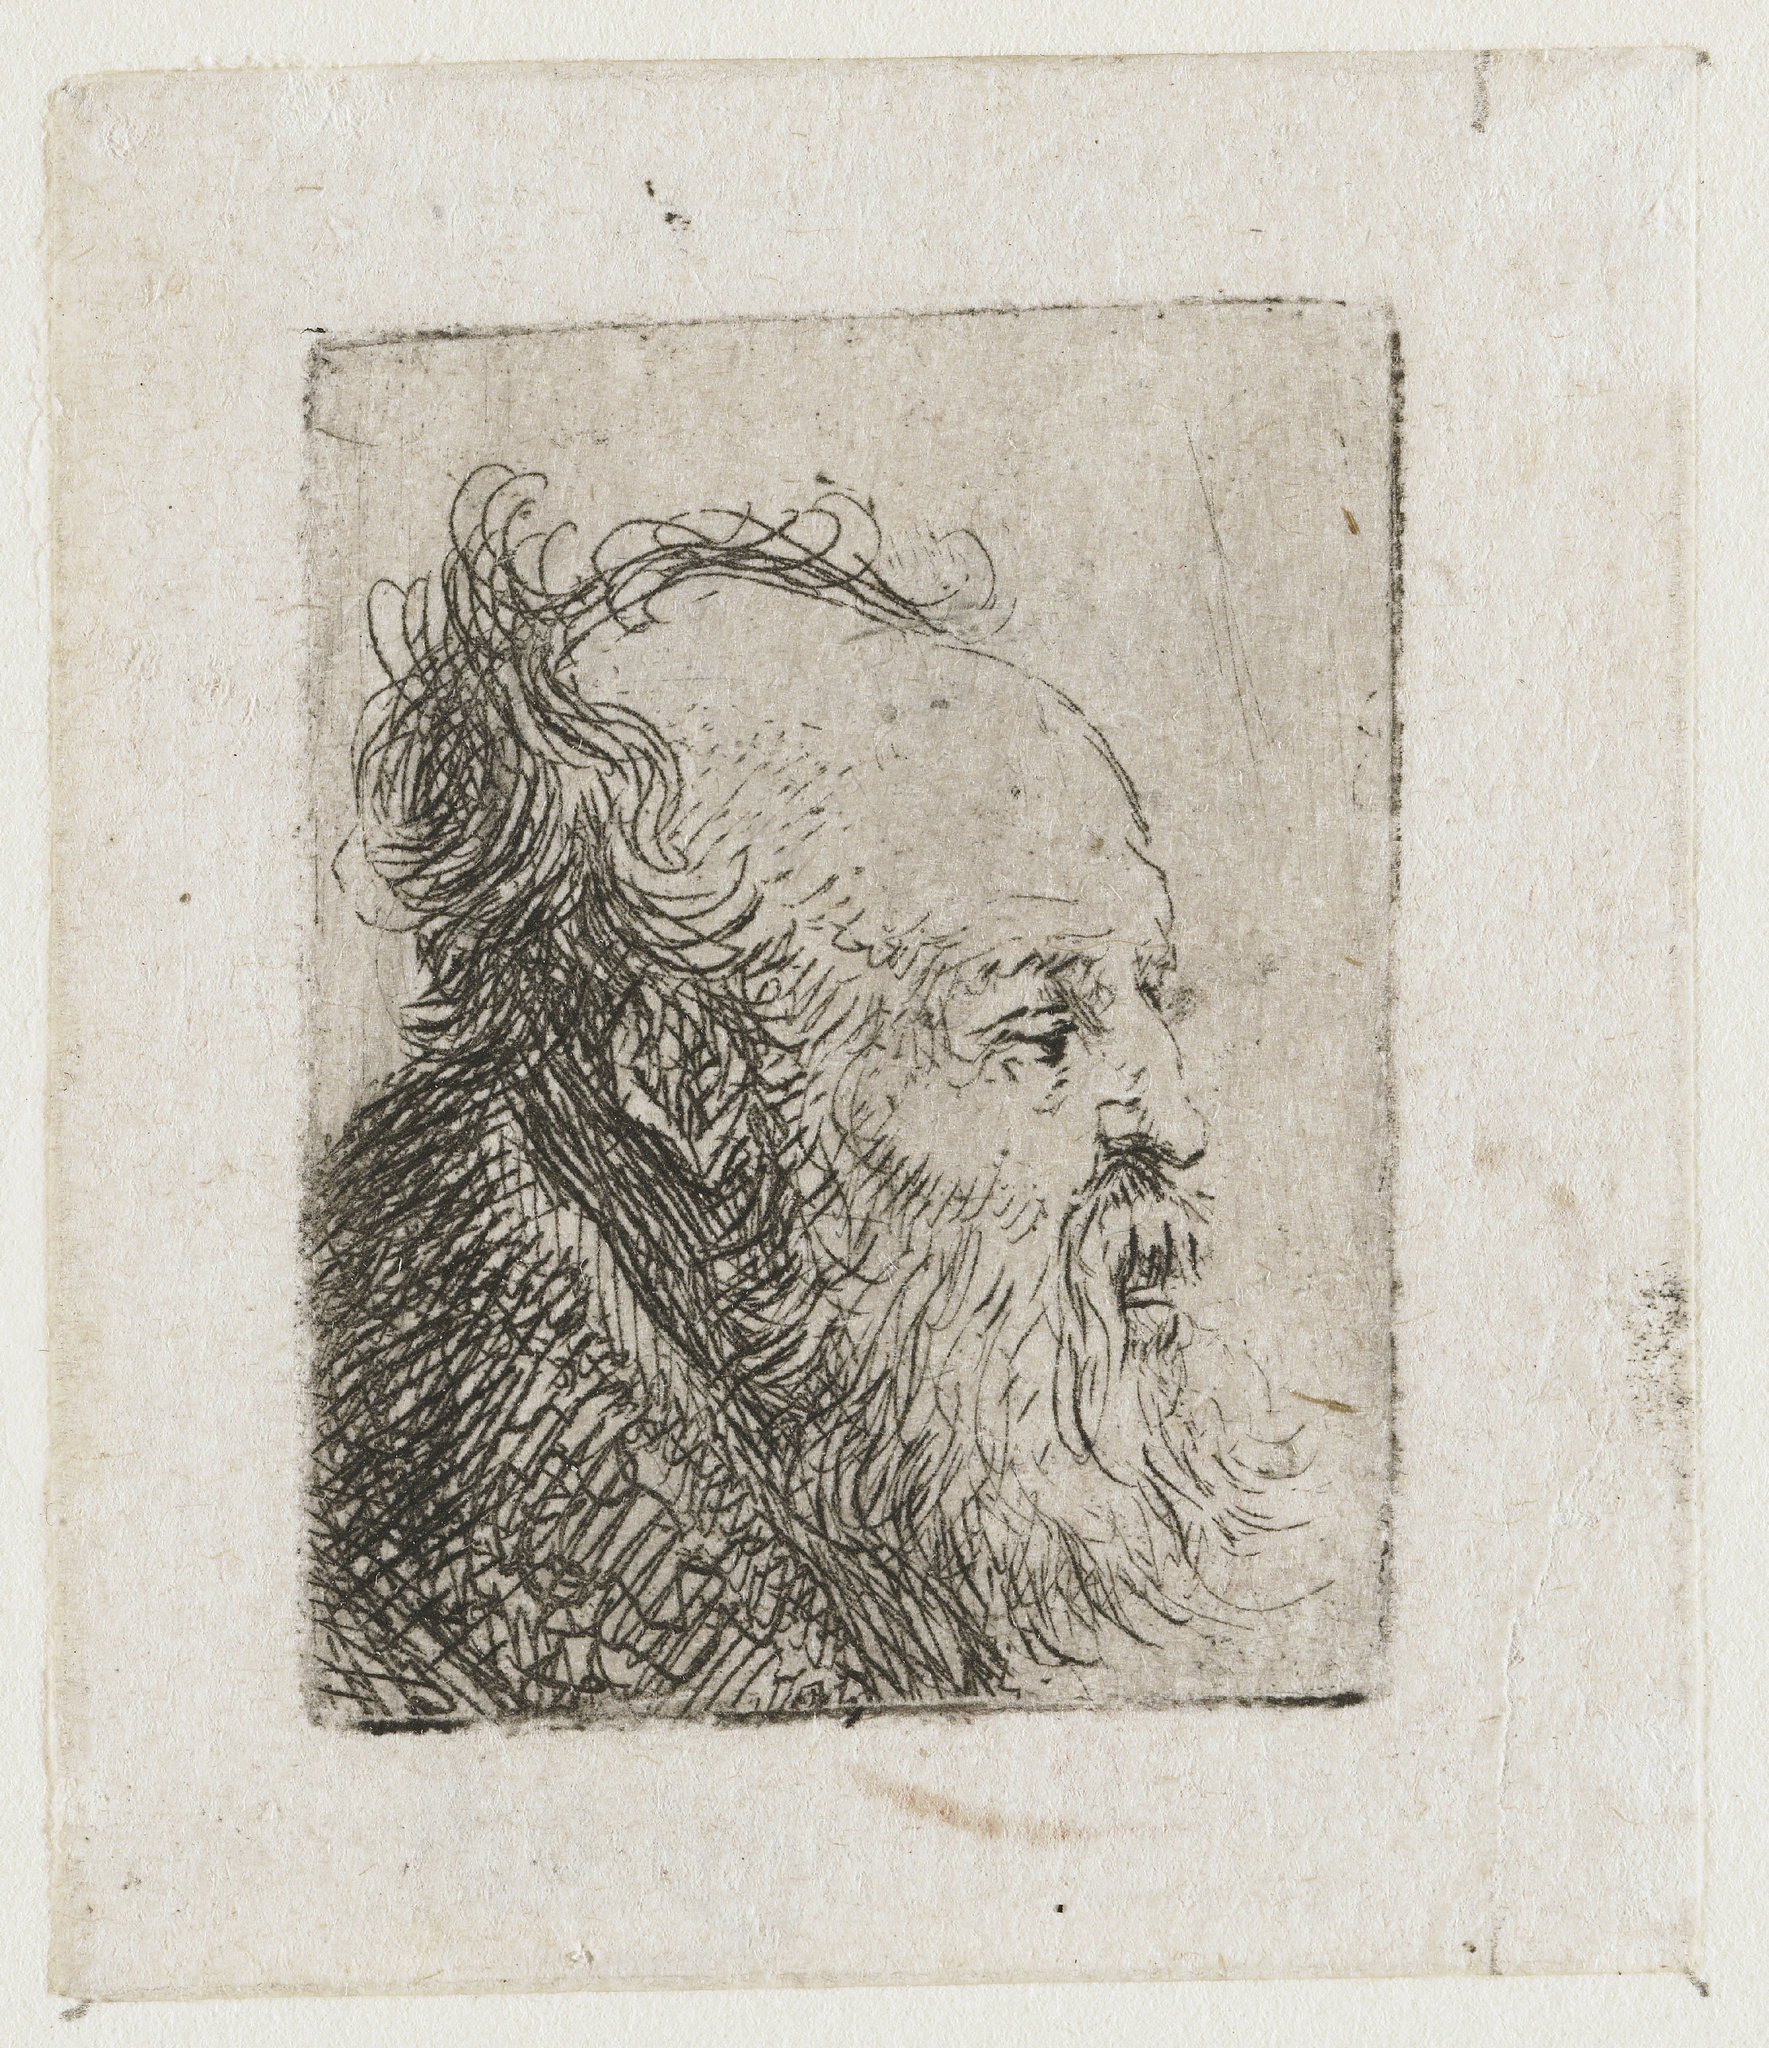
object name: print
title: Sheet of studies of men's heads: old bearded man nearly in profile to right: mouth half open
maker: rembrandt van rijn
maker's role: draughtsman, painter, print maker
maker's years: 1606-1669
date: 1629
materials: paper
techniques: etching, intaglio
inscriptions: collector's mark: Lugt 240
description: Another five small depictions of men’s heads, but this time it is certain that they did not originate as independent prints. Originally, they were all on the same copperplate. After Rembrandt cut up the plate, he completed each print individually. This working method was unusual and characterizes Rembrandt as an artist who often strayed off the beaten path.